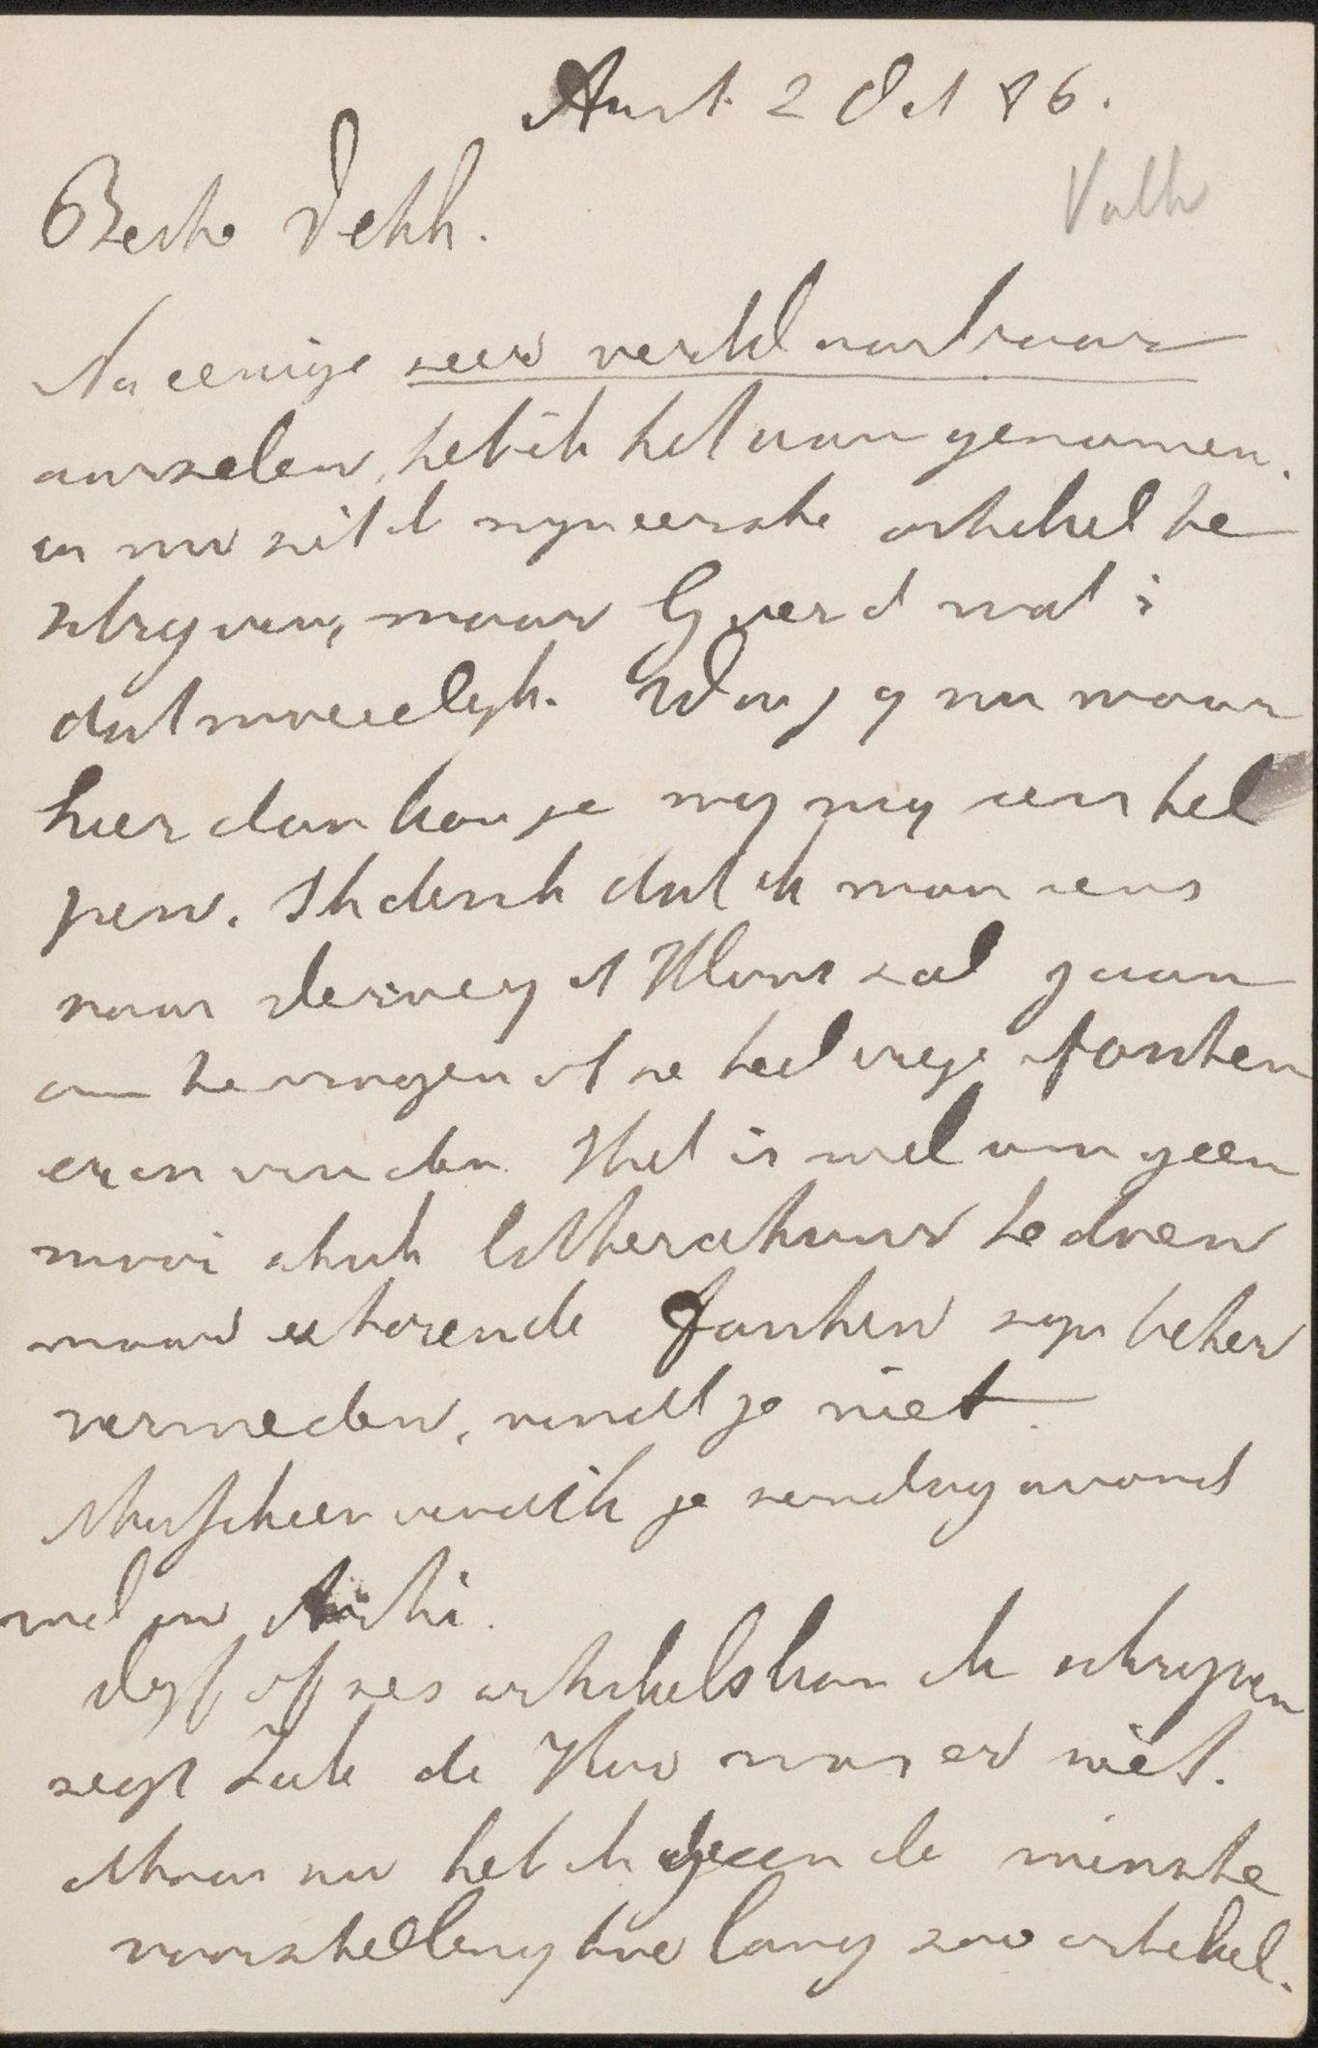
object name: letter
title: Brief aan Jan Veth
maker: maurits van der valk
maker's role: draughtsman, print maker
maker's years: 1857-1935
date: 1886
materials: ink, paper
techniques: pen, writing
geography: amsterdam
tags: dordrecht, painter, designer, jan veth, painting (including book-illumination, miniature-painting), historical persons (portraits and scenes from the life), printed matter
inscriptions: collector's mark: ‘RPK’